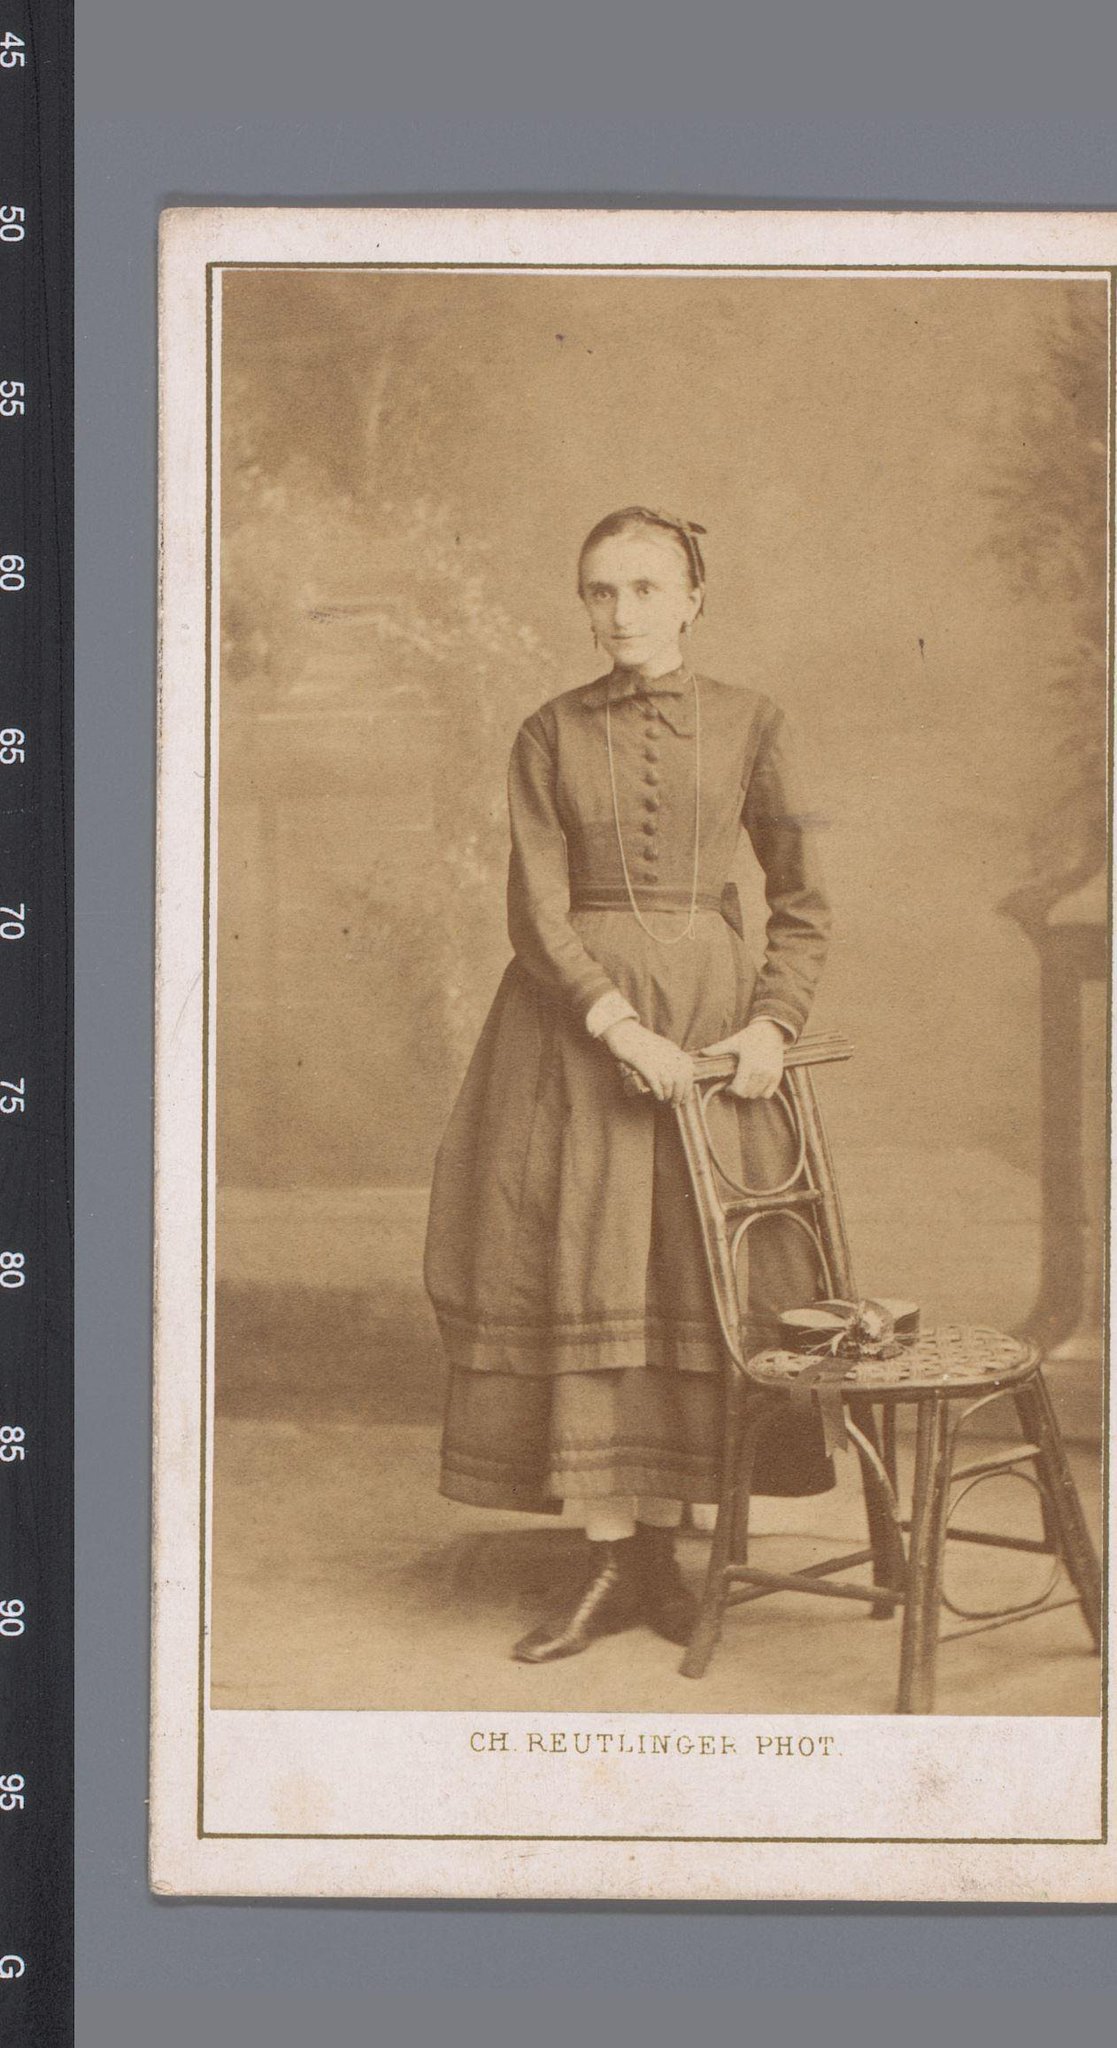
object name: carte de visite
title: Portret van een onbekend meisje bij een stoel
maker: charles reutlinger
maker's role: publisher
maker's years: 1816-1880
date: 1867-1880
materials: cardboard, paper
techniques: albumen print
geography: paris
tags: adolescent, young woman, maiden, anonymous historical person portrayed, paris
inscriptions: inscription: ‘Ch. Reutlinger phot.’, inscription: ‘Paris 1867 Berlin 1866/ Premier Prix/ Exposition Universelle 1867/ Ch. Reutlinger/ Photographe/ 21, Boulevard Montmartre, 21/ Paris/ Les Clichés étant conservés indéfiniment/ on peut toujours se procurer de nouvelles/ épreuves de Cartes & Portraits sans reposer.’